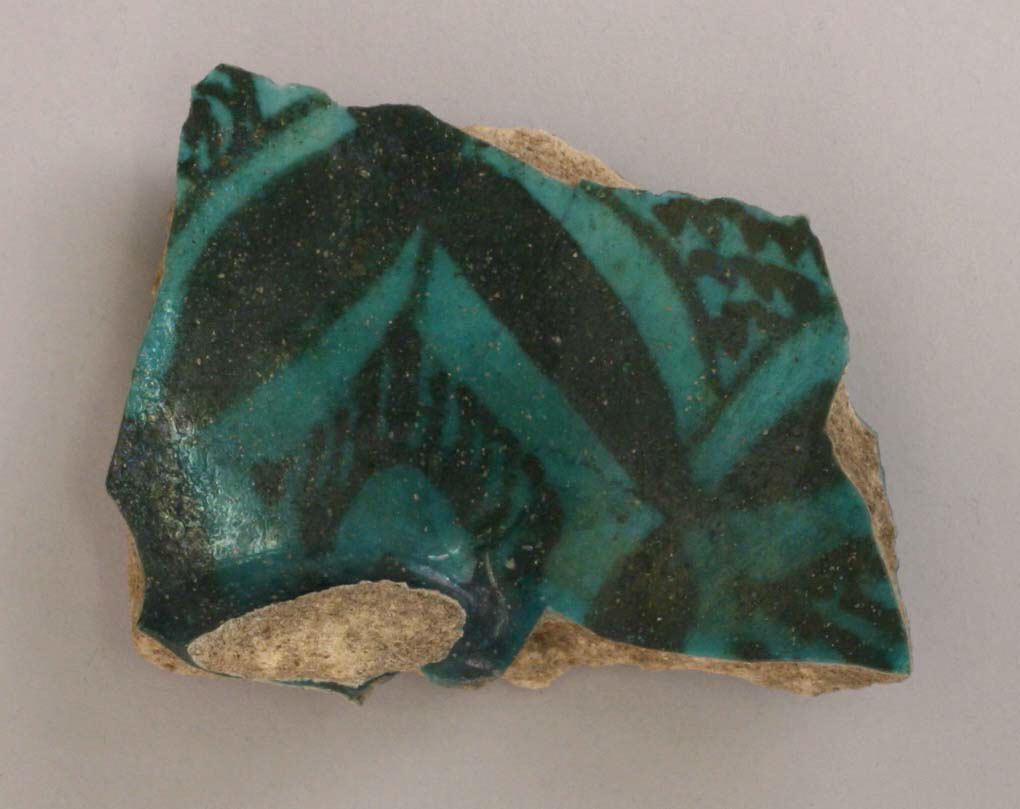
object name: fragment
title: Ceramic Fragment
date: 1301-1500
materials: glaze, stonepaste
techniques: painting, underglaze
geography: syria